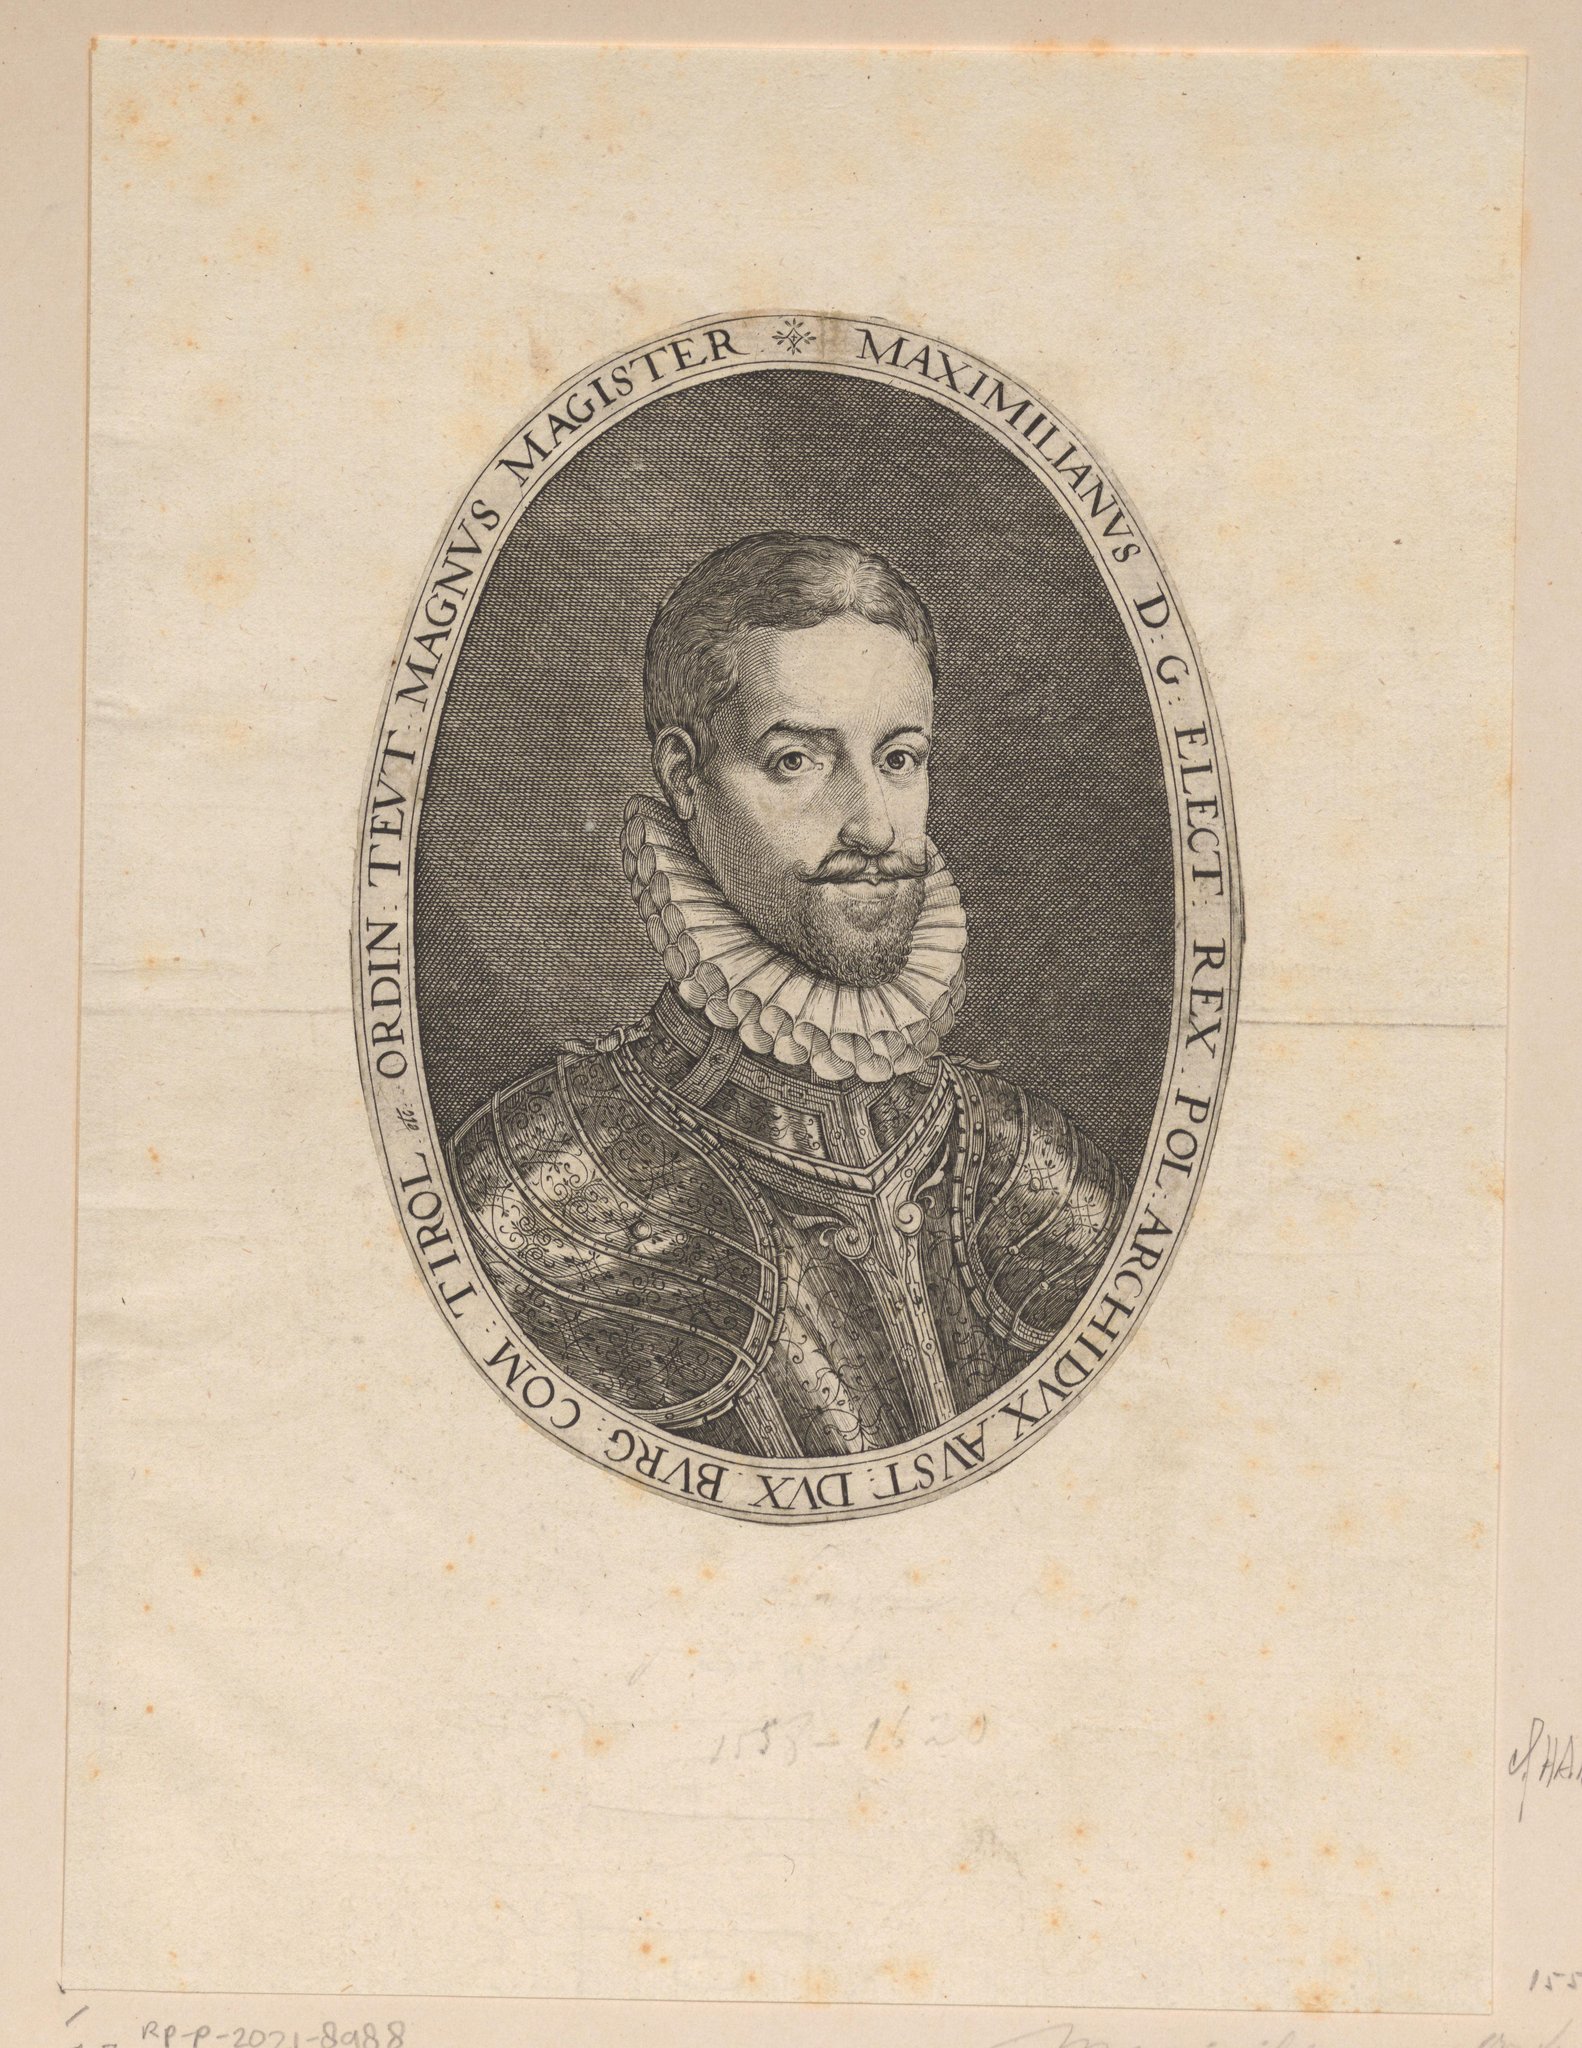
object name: print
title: Portret van Maximiliaan III van Oostenrijk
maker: Anonymous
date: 1587-1630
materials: paper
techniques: engraving, snipping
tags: vienna, maximiliaan iii (aartshertog van oostenrijk), armour, historical persons, knighthood order of the golden fleece - insignia of a knighthood order, e.g.: badge, chain (with name of order)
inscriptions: inscription: ‘Max. II. fil. +1620.’